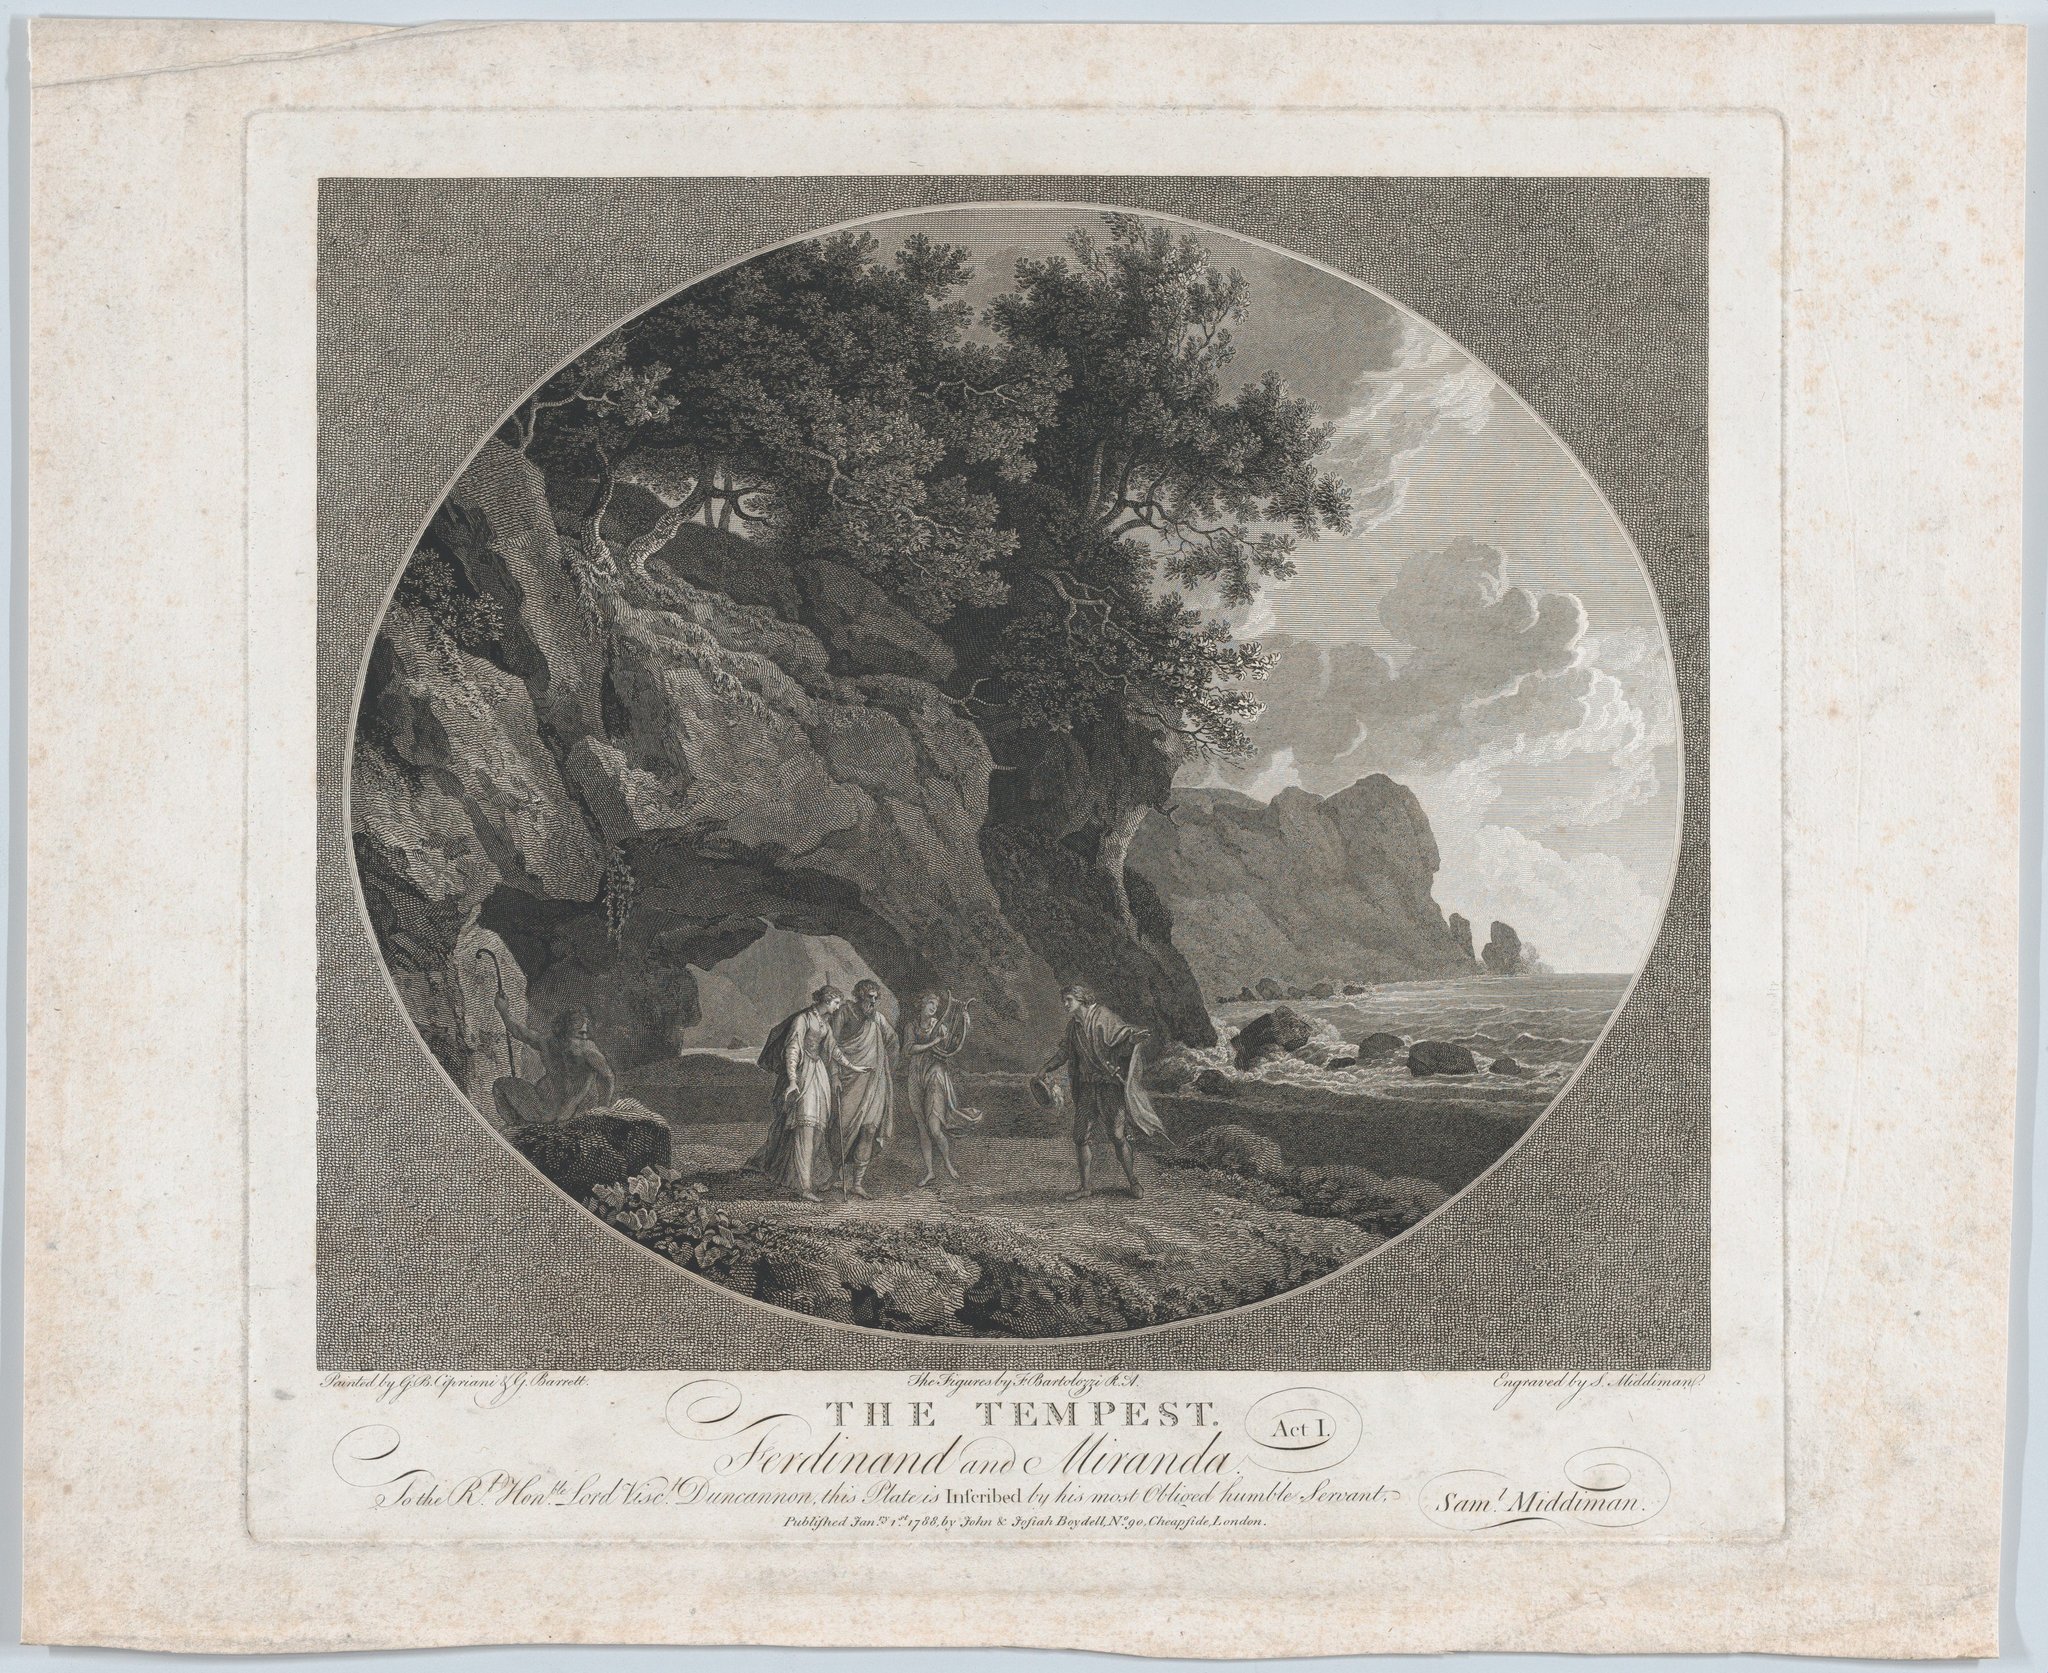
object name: print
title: The Tempest, Act I: Ferdinand and Miranda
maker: samuel middiman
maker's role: engraver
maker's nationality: british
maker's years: 1751-1831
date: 1788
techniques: etching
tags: shakespeare,men,women,caves